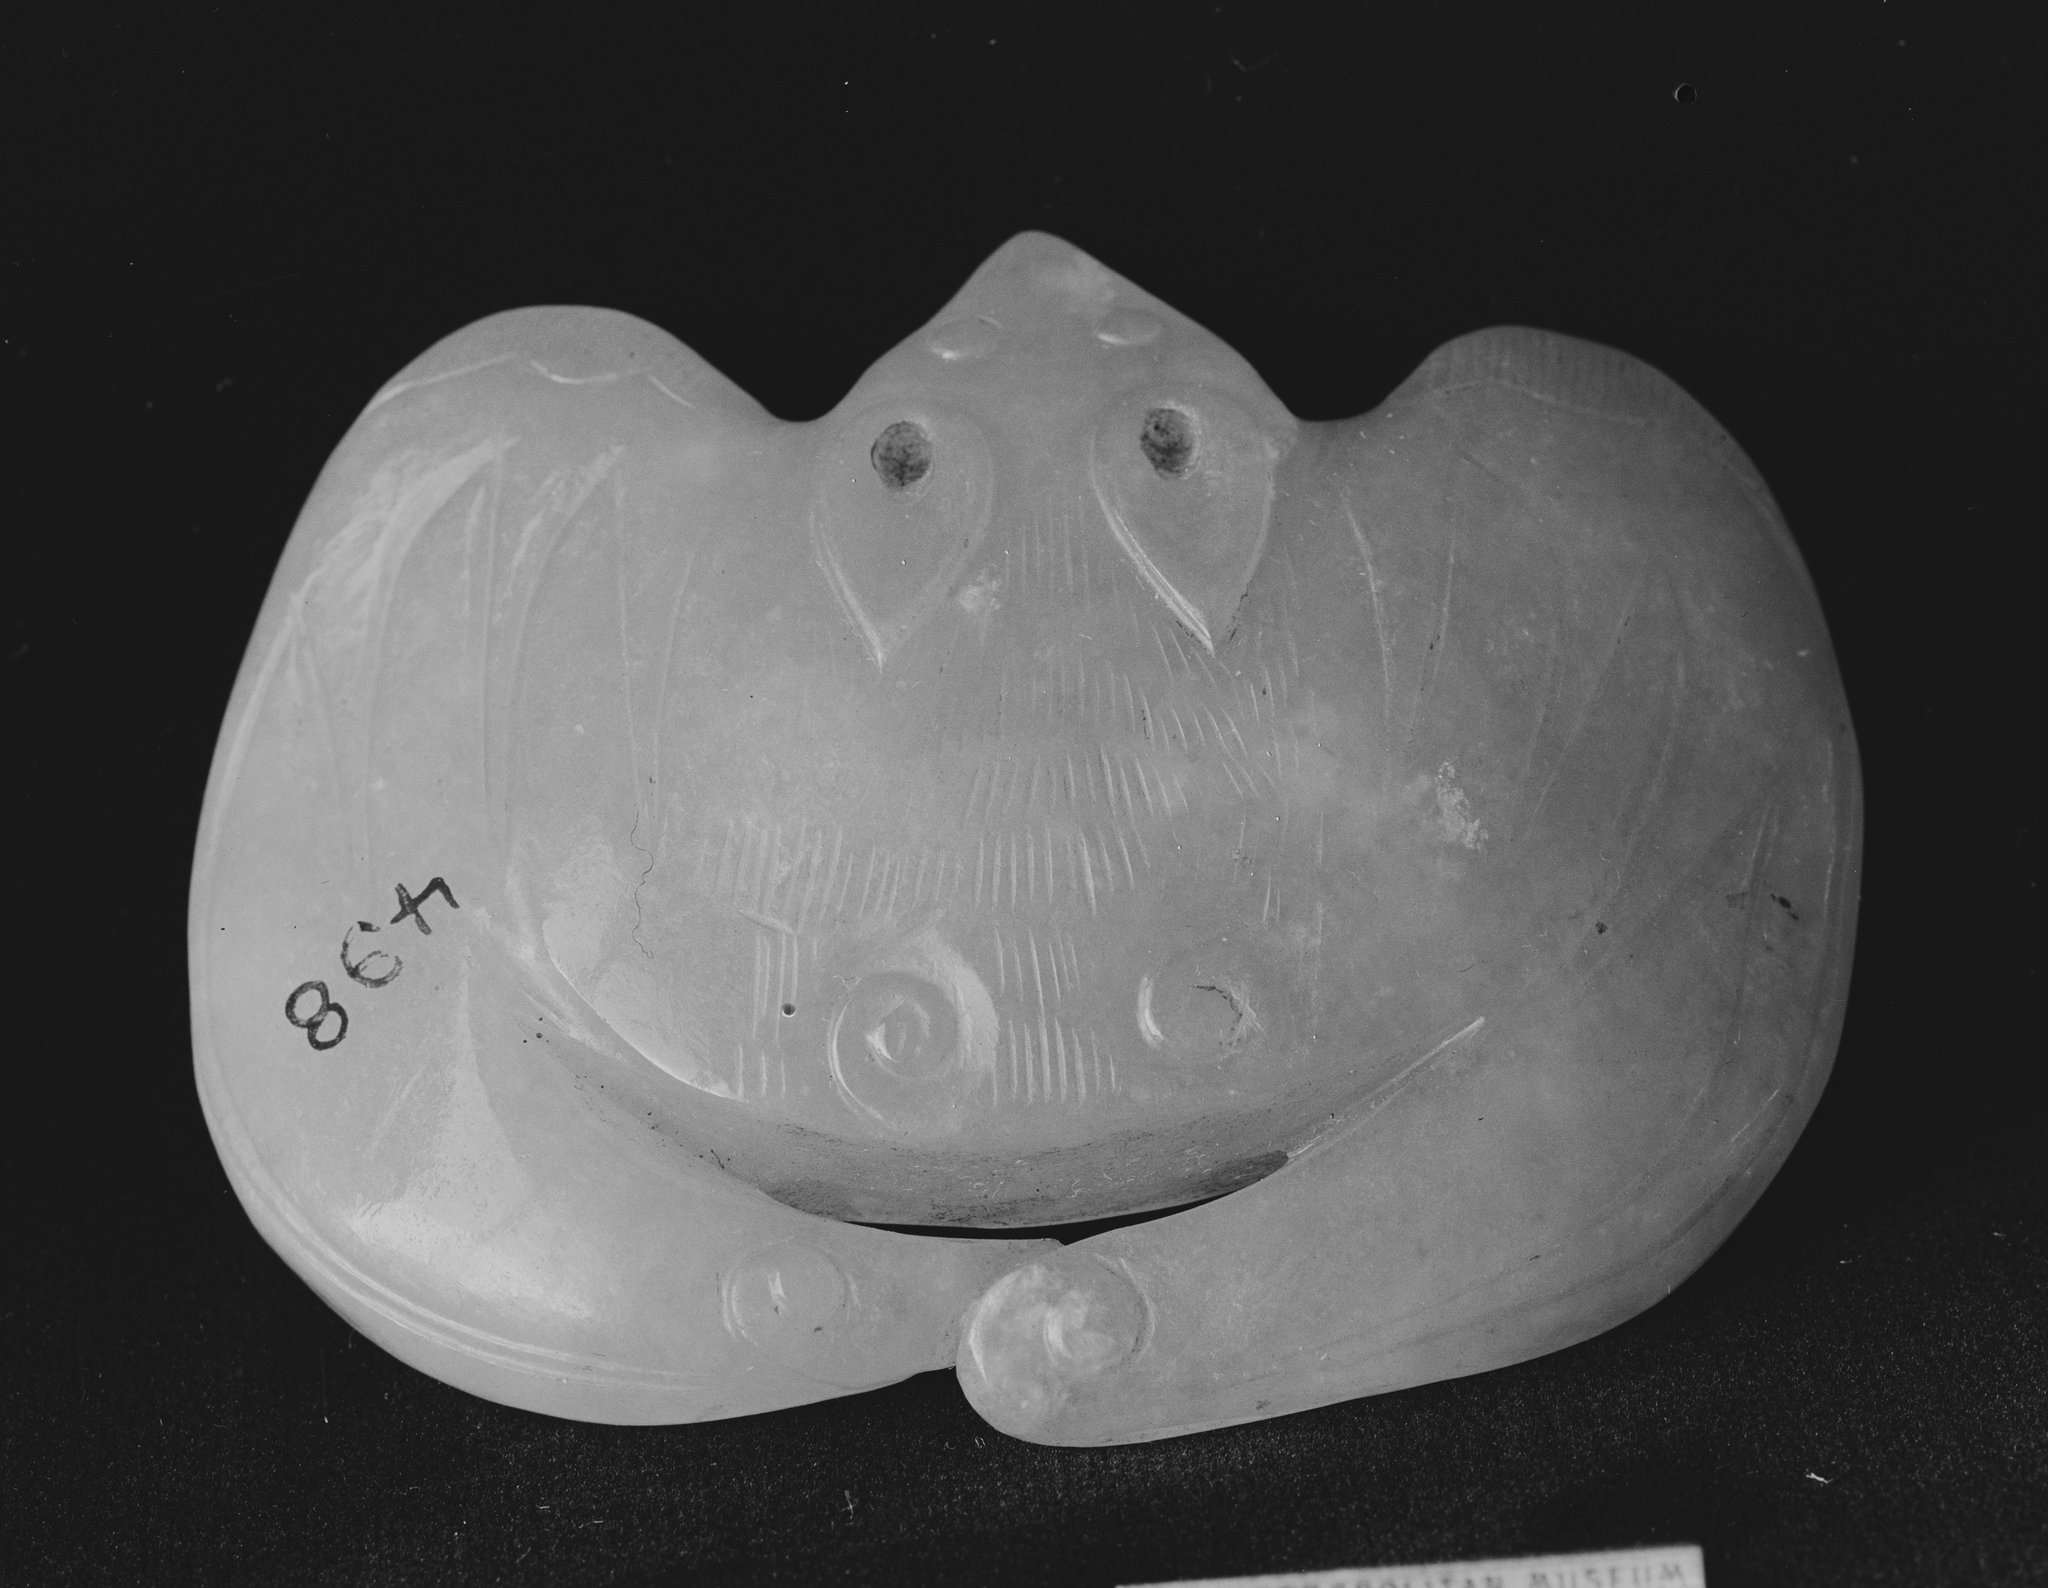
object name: girdle clasp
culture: chinese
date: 1736-1795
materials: jade